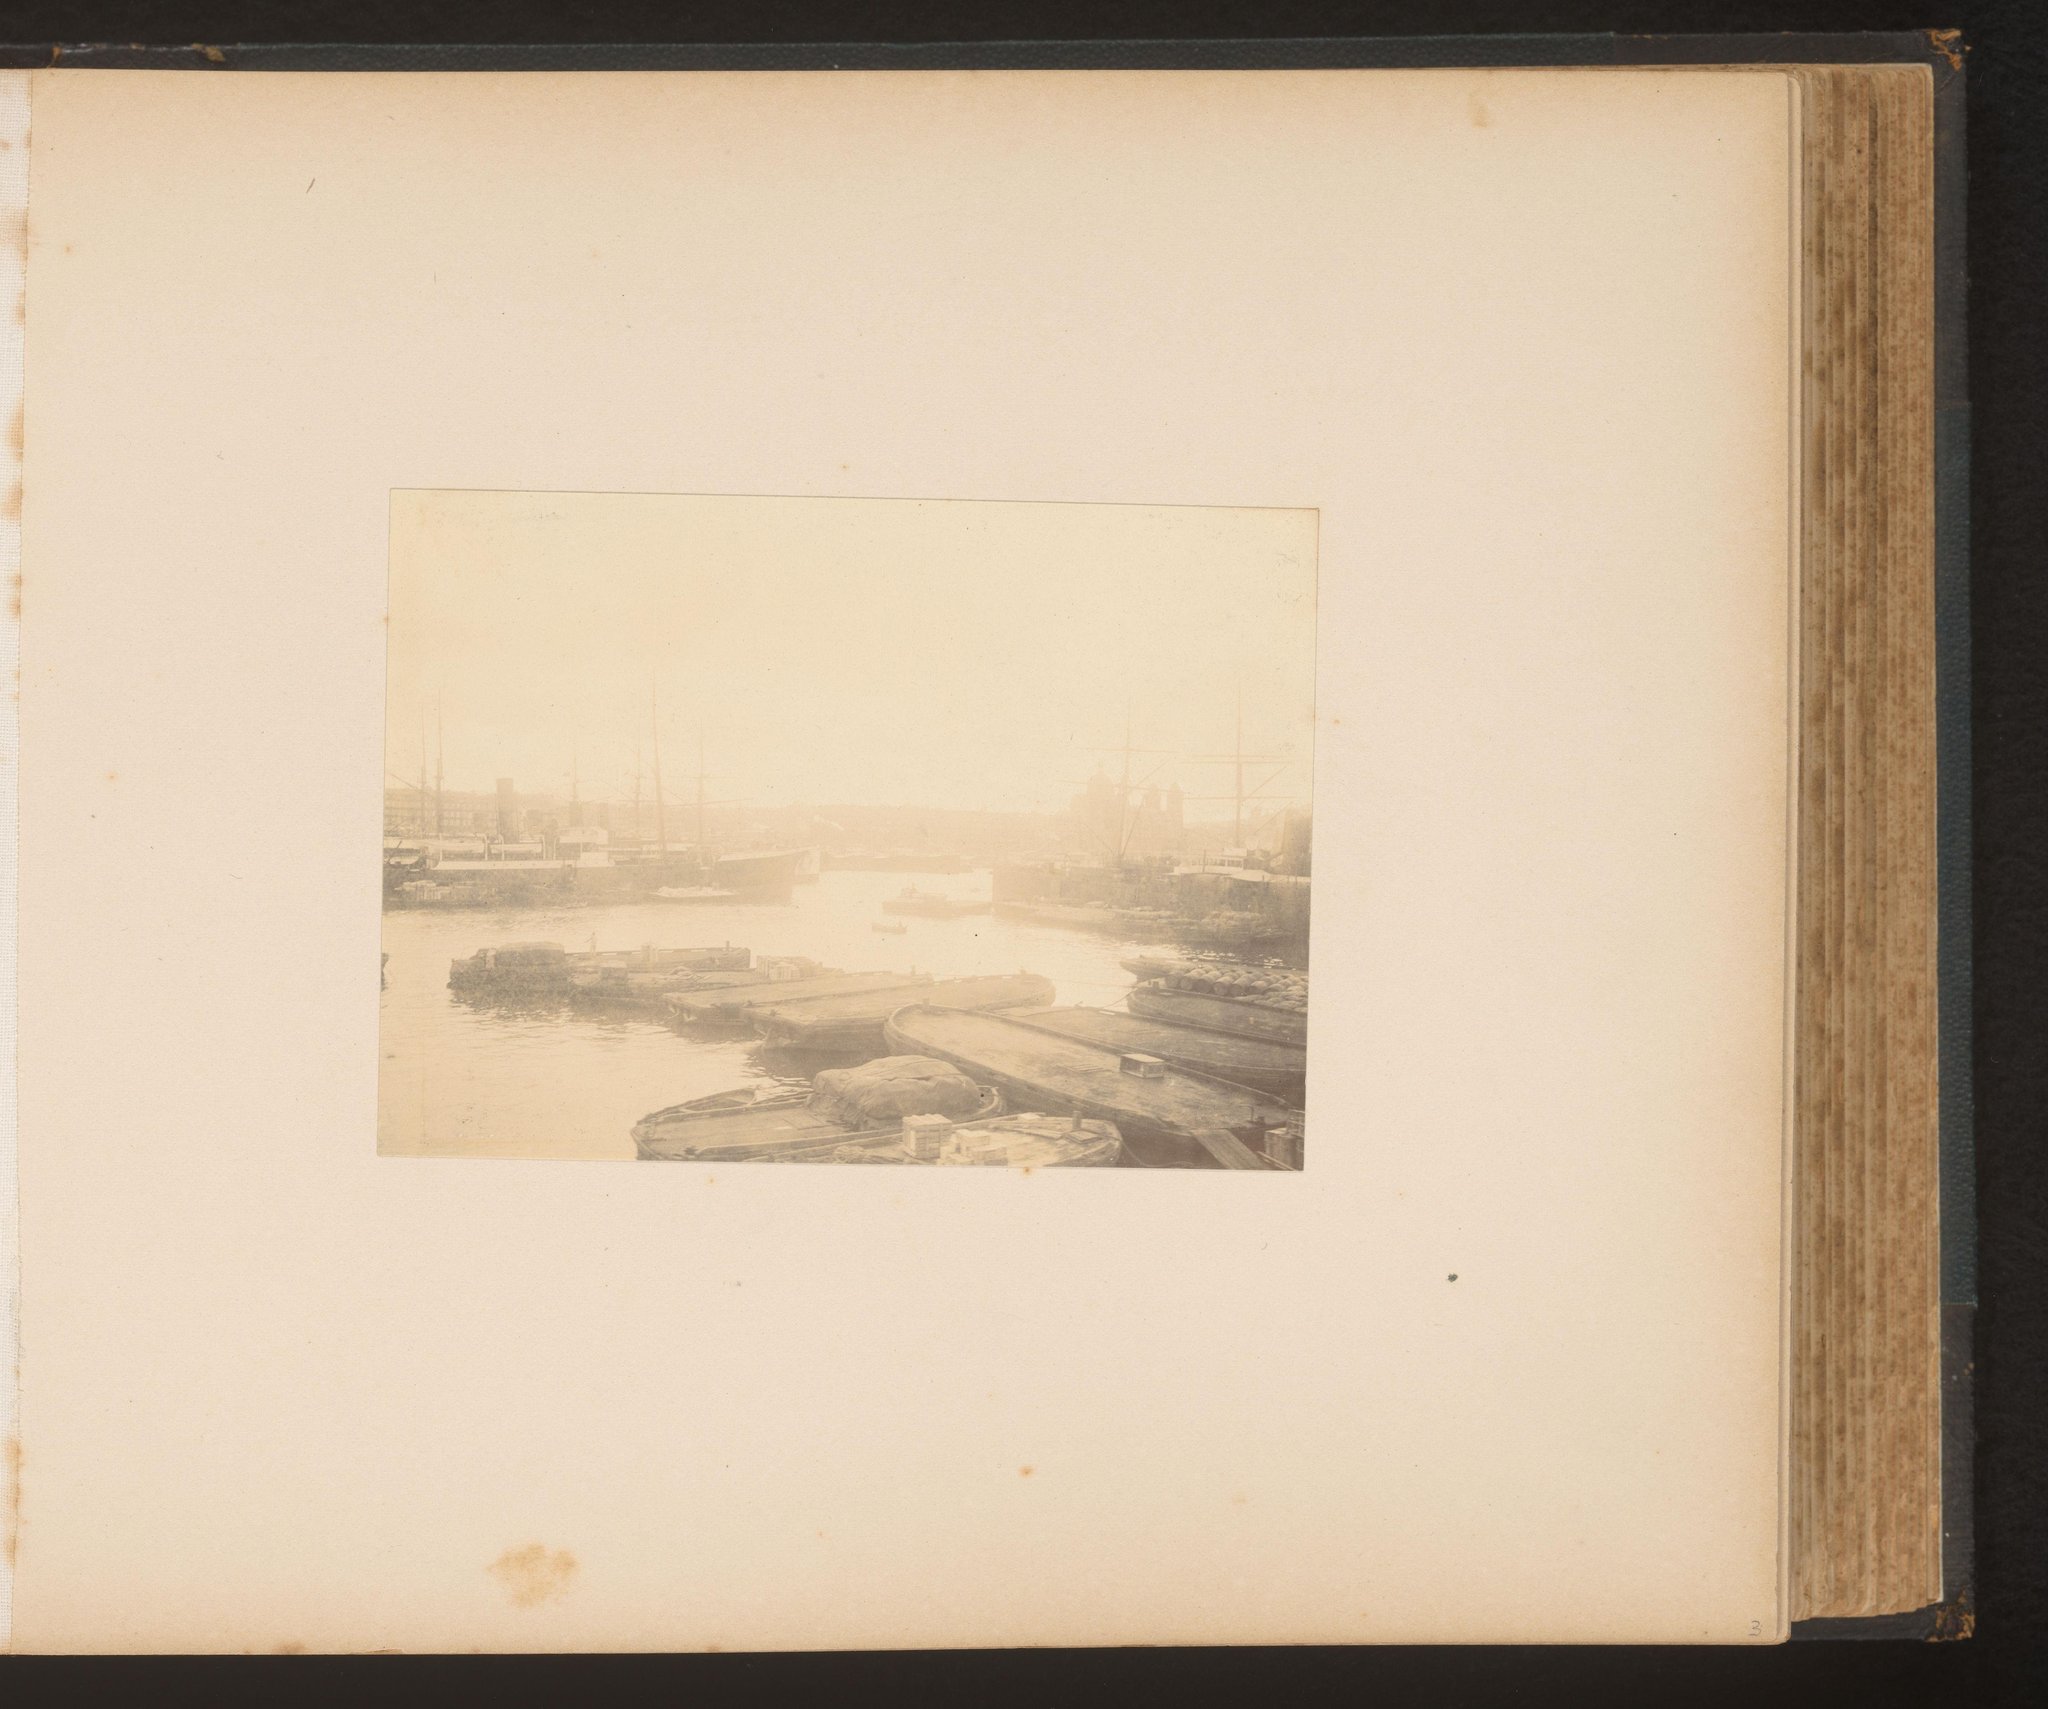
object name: photograph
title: Boten in een haven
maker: Anonymous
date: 1880-1920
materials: cardboard, photographic support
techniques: gelatin silver print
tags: harbour, ships (in general), france